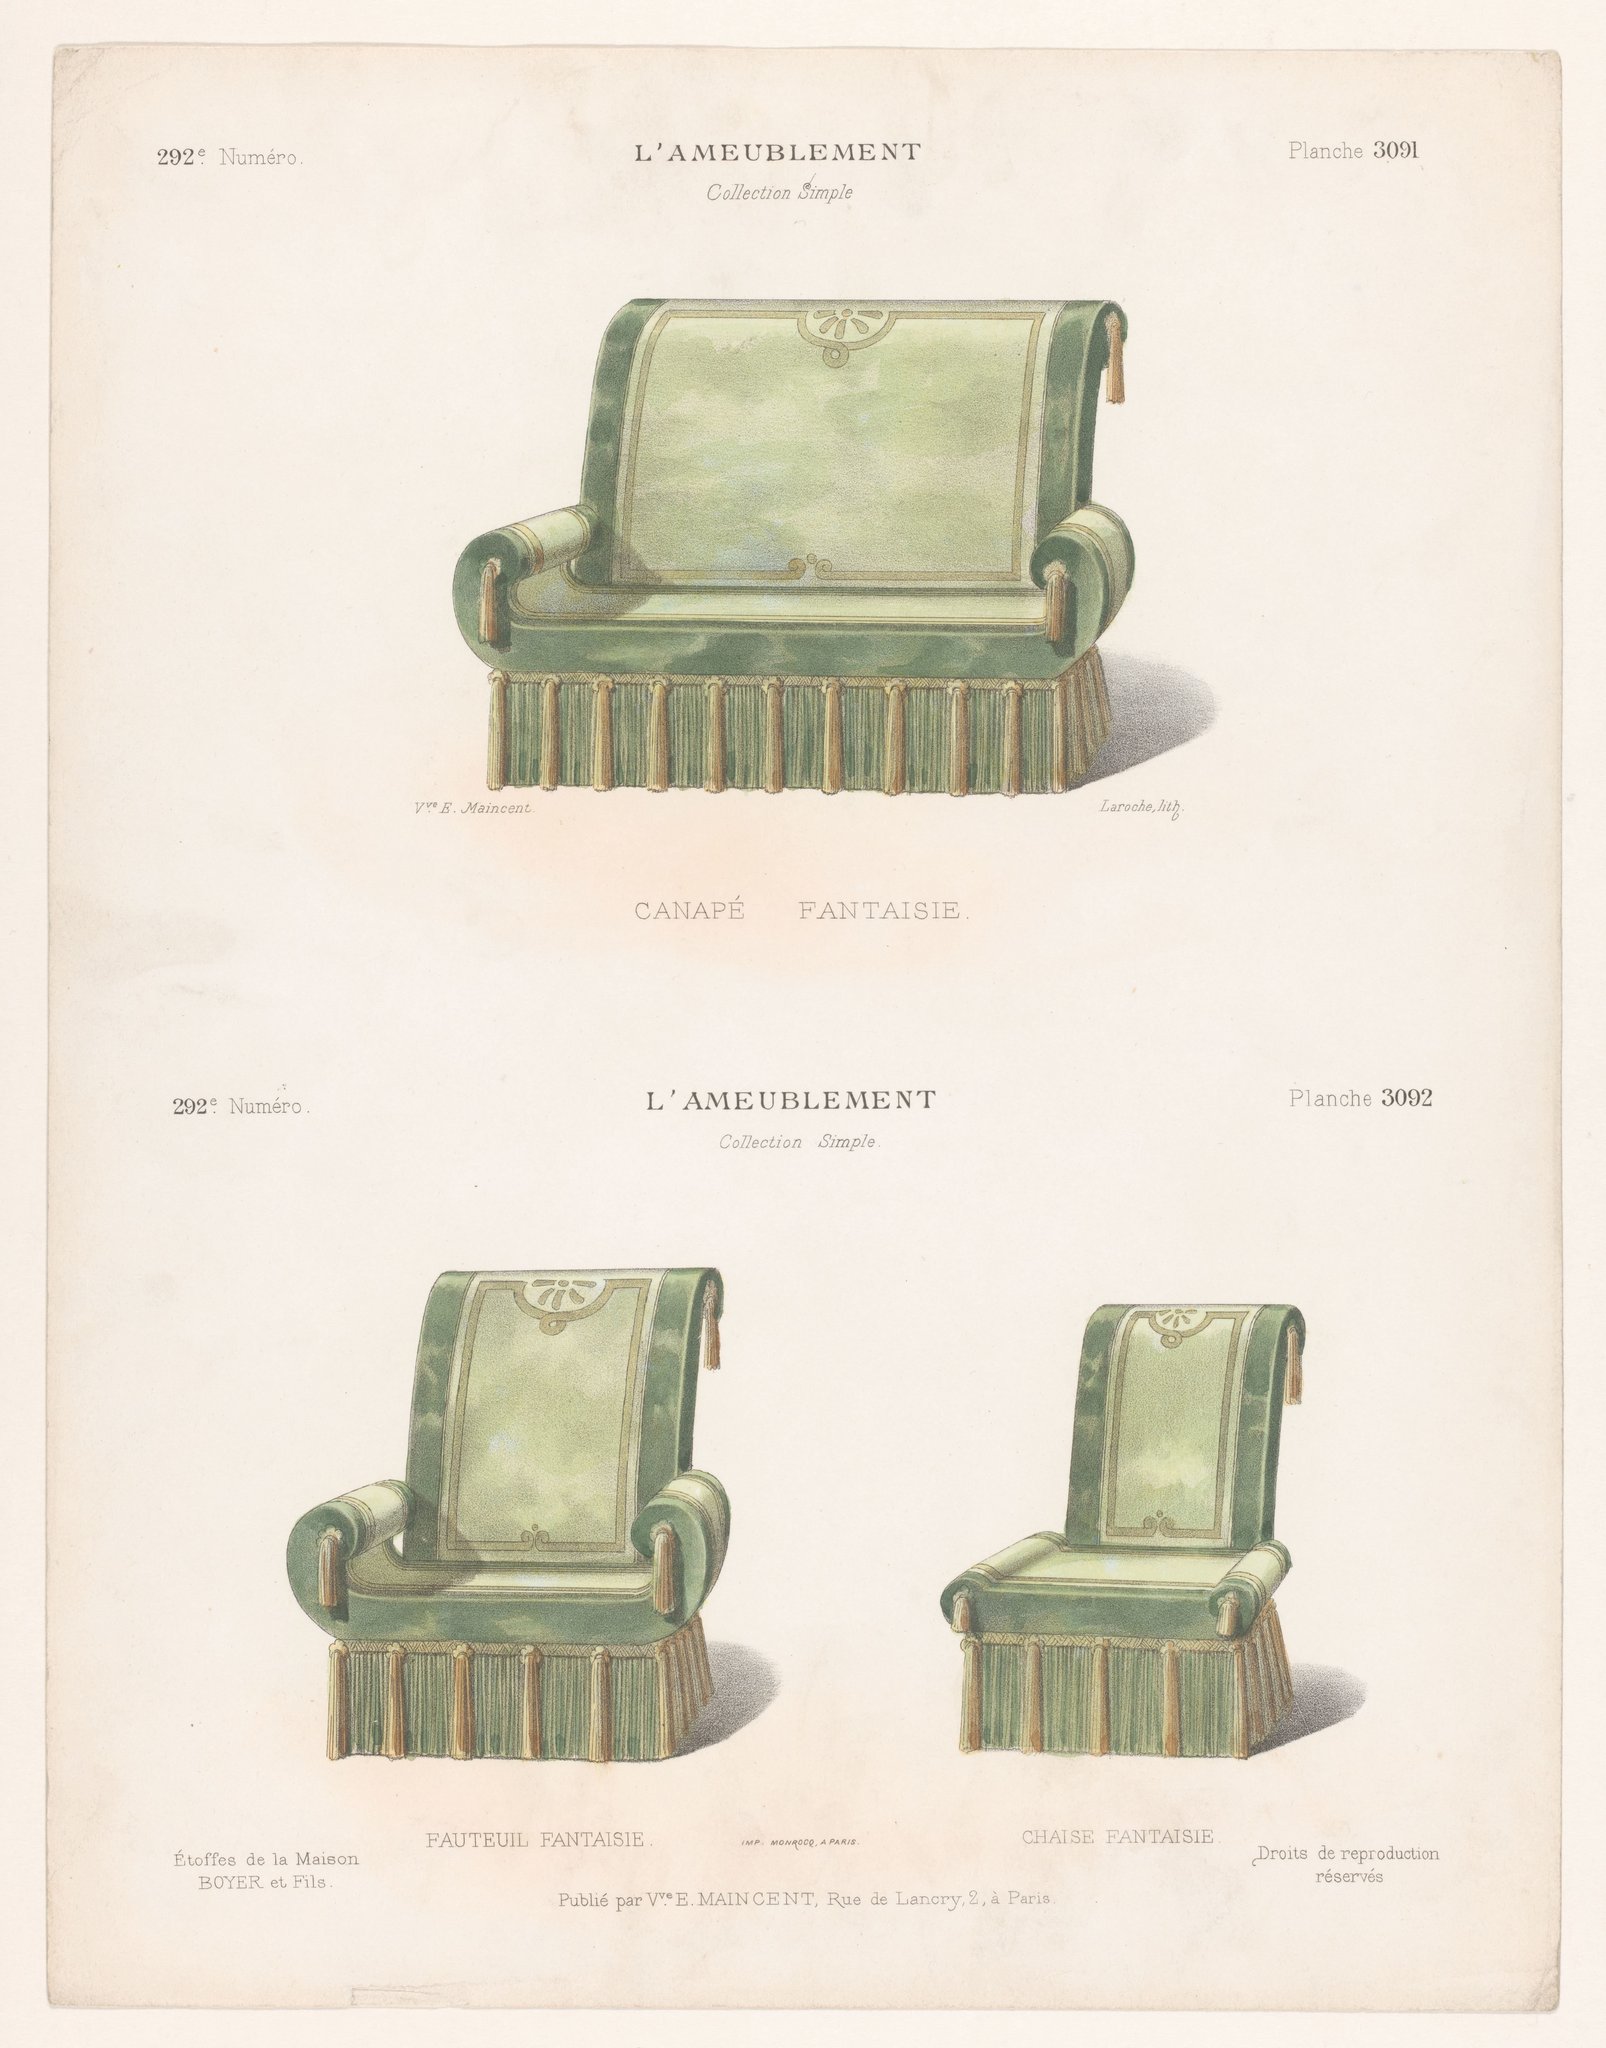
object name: print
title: Canapé, fauteuil en stoel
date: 1895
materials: paper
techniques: hand coloring, lithograph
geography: paris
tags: seating furniture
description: Een canapé, fauteuil en een stoel. Prent uit 292e nummer (livraison).